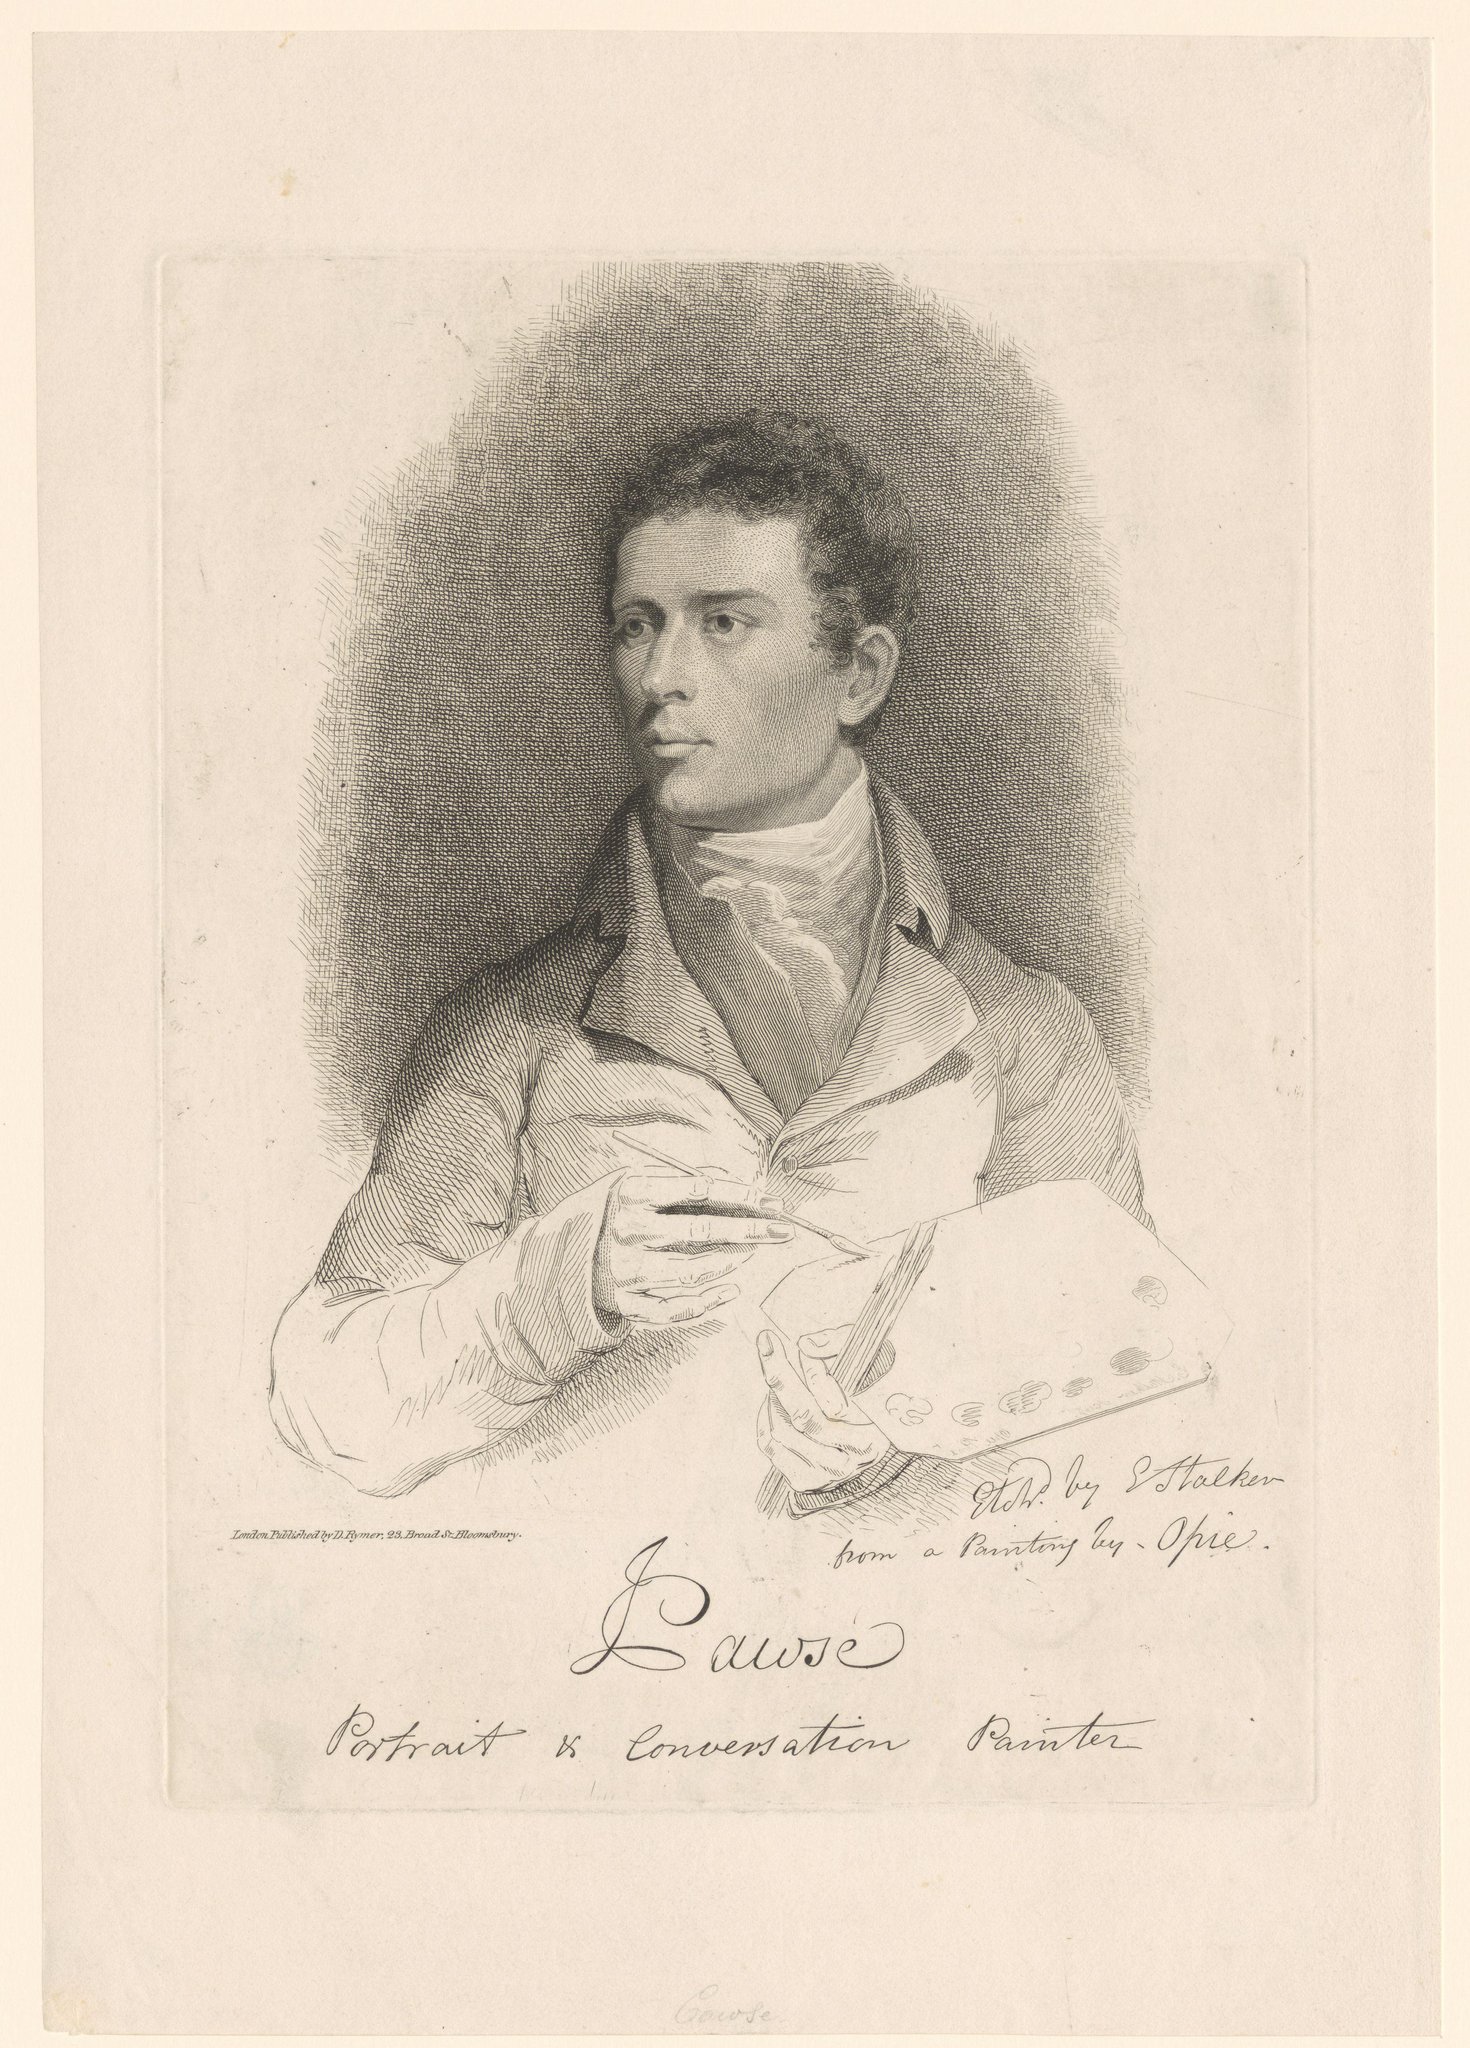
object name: print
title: J Cawse Portrait & Conversation Painter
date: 1800-1847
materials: paper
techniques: etching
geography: london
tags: draughtsman, john cawse, historical persons, portrait, self-portrait of artist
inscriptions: collector's mark: Lugt 2760, collector's mark: Lugt 4347, collector's mark: Lugt 2228